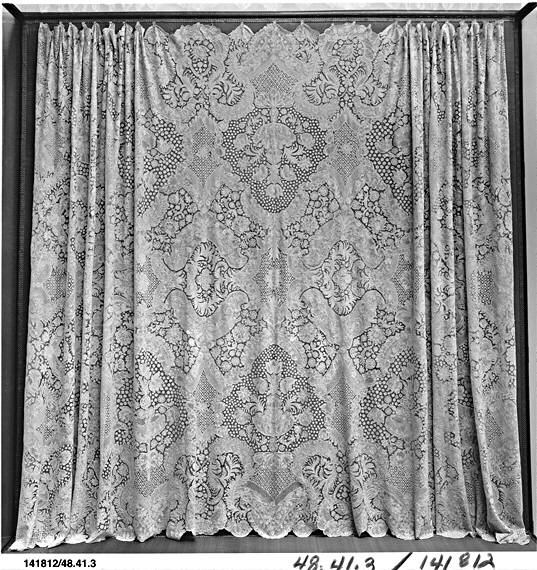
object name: cover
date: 1701-1733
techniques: lace